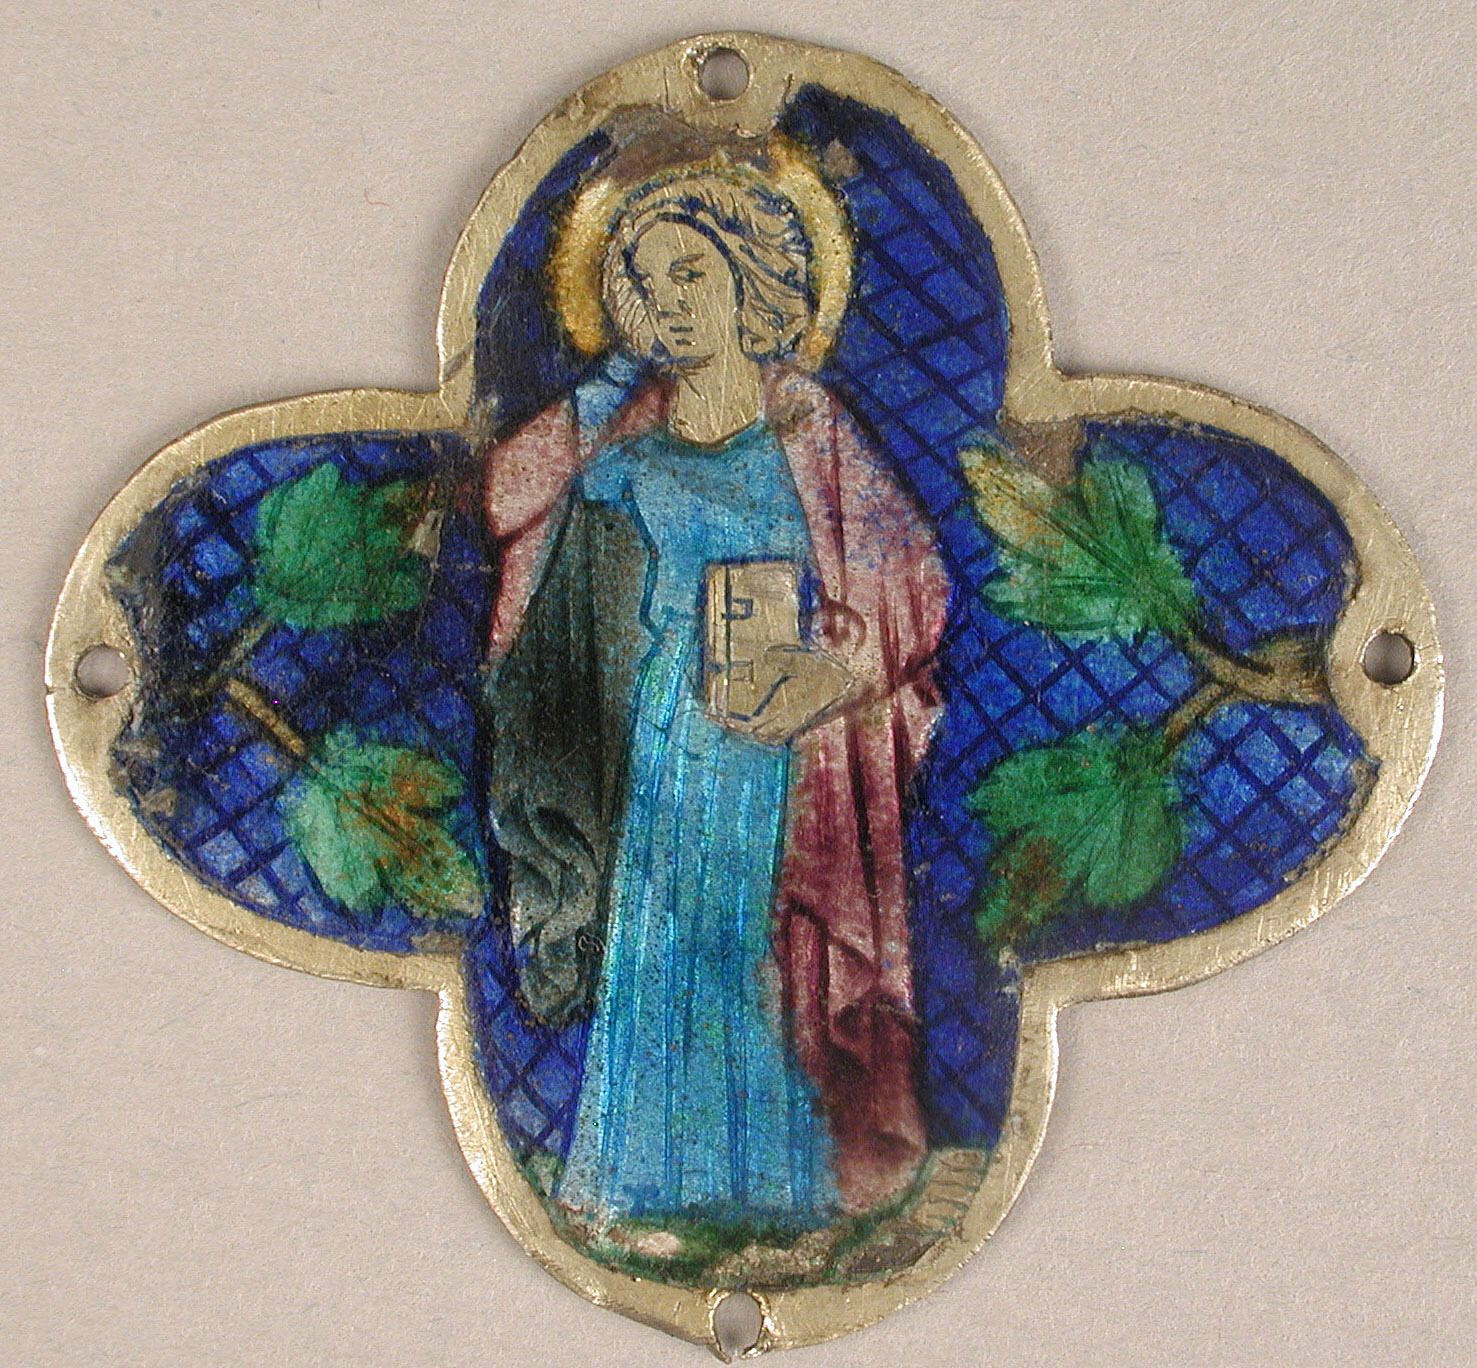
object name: plaque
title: Plaque with St. John in Mourning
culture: catalan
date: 1301-1400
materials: enamel, silver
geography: spain